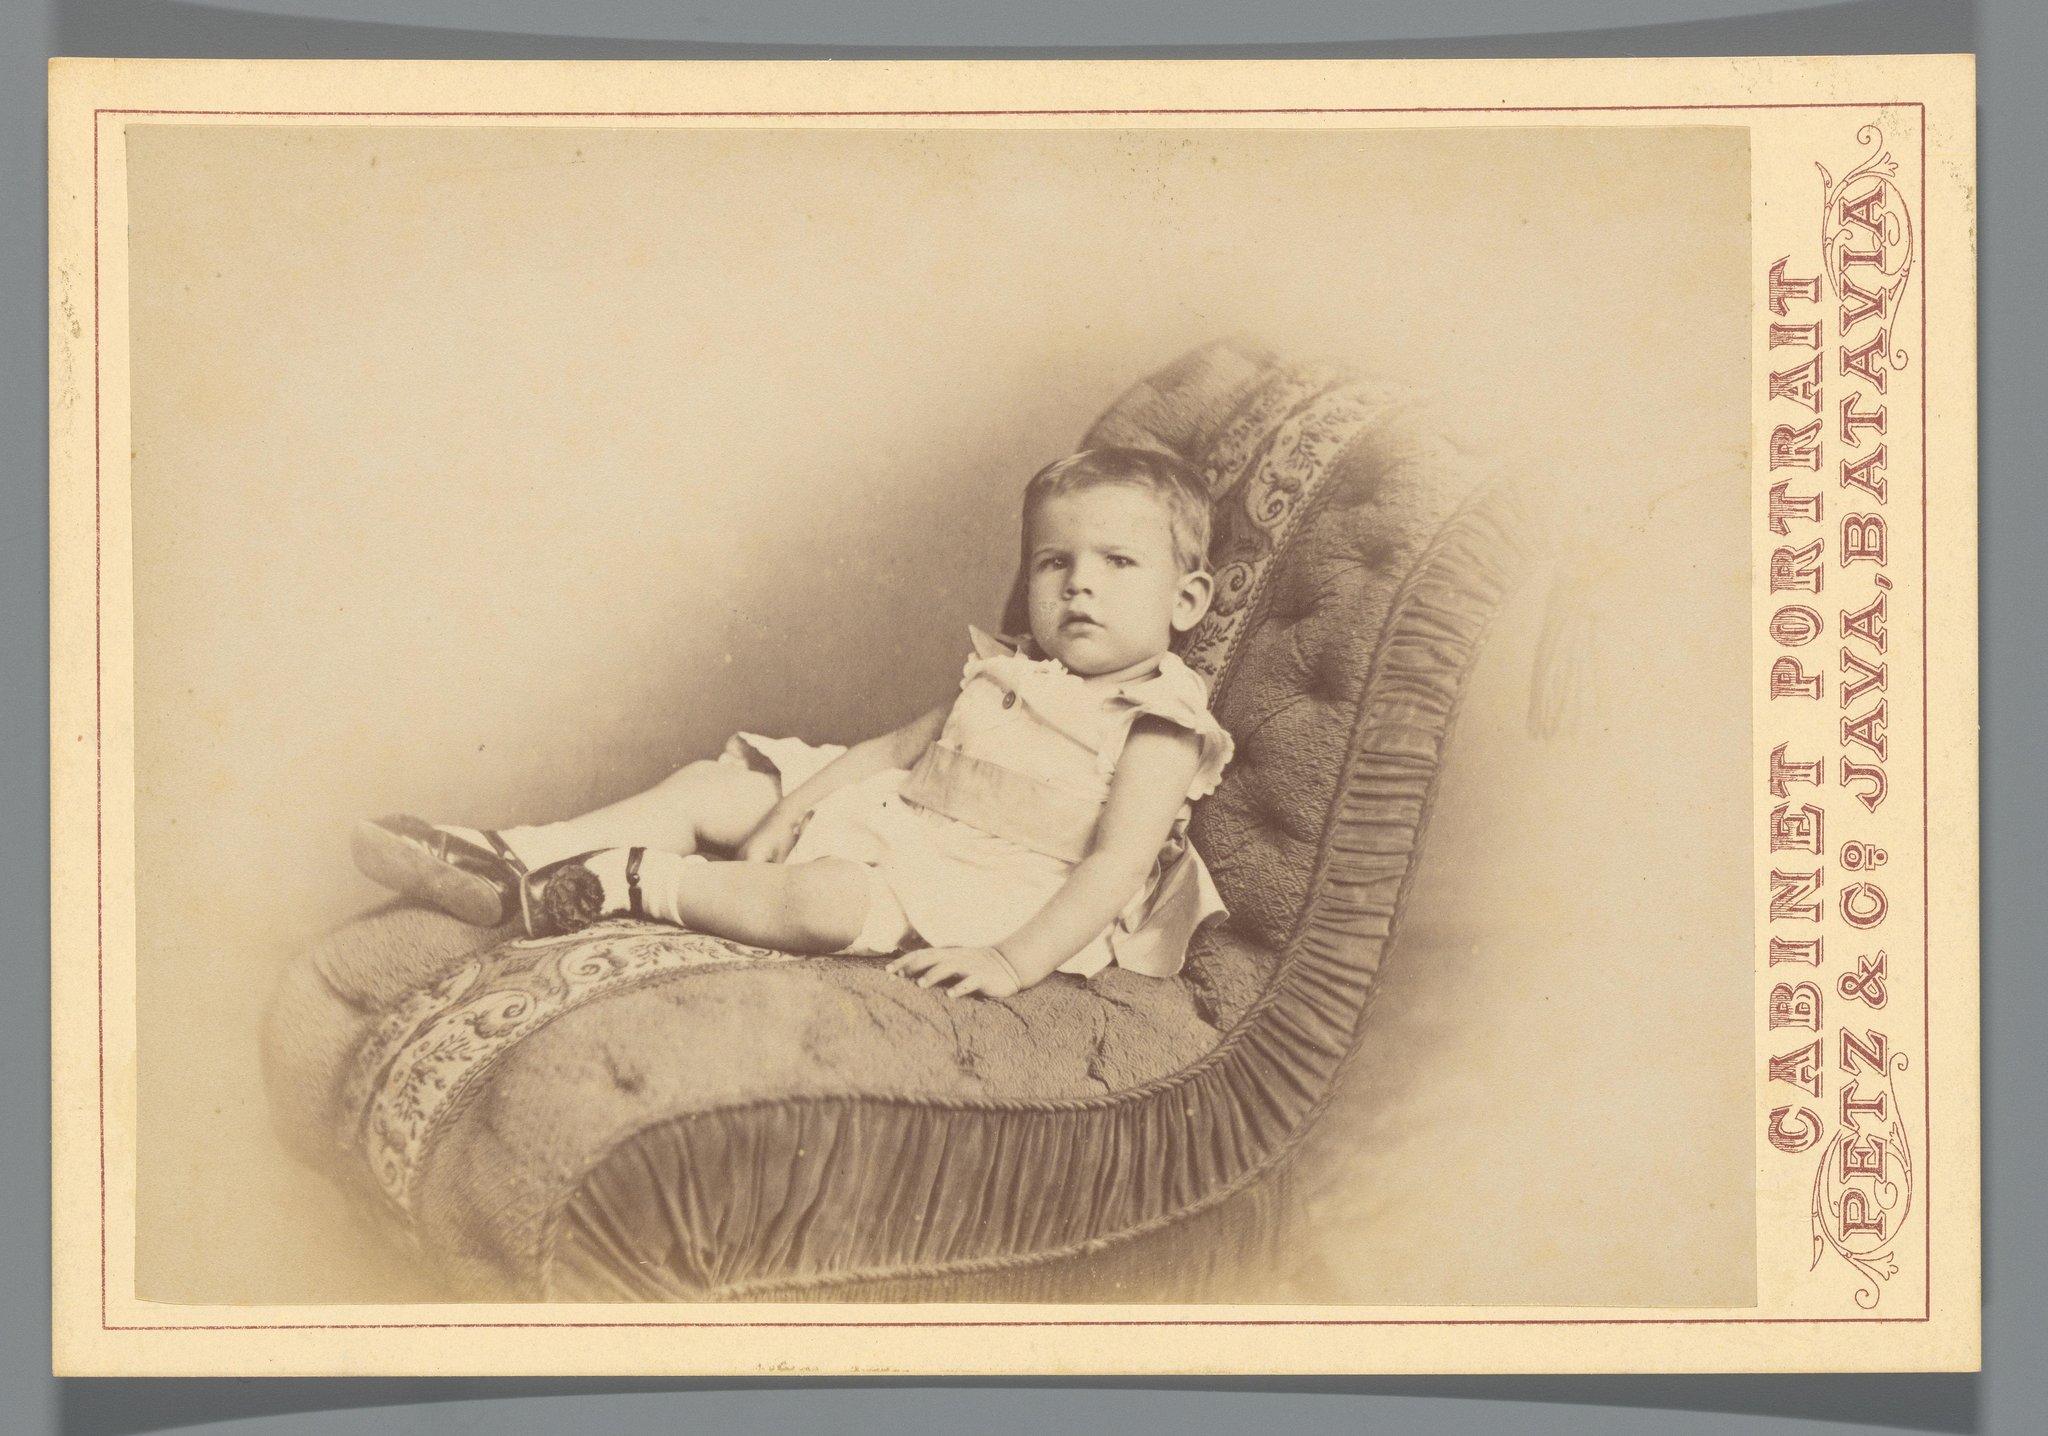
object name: cabinet photograph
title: Portret van Hendrik Herman van den Berg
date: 1880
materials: cardboard, photographic support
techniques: albumen print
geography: java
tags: batavia, amsterdam, hendrik herman van den berg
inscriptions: inscription: ‘CABINET PORTRAIT / PETZ & Co JAVA, BATAVIA’, name: ‘H.H van den Berg’